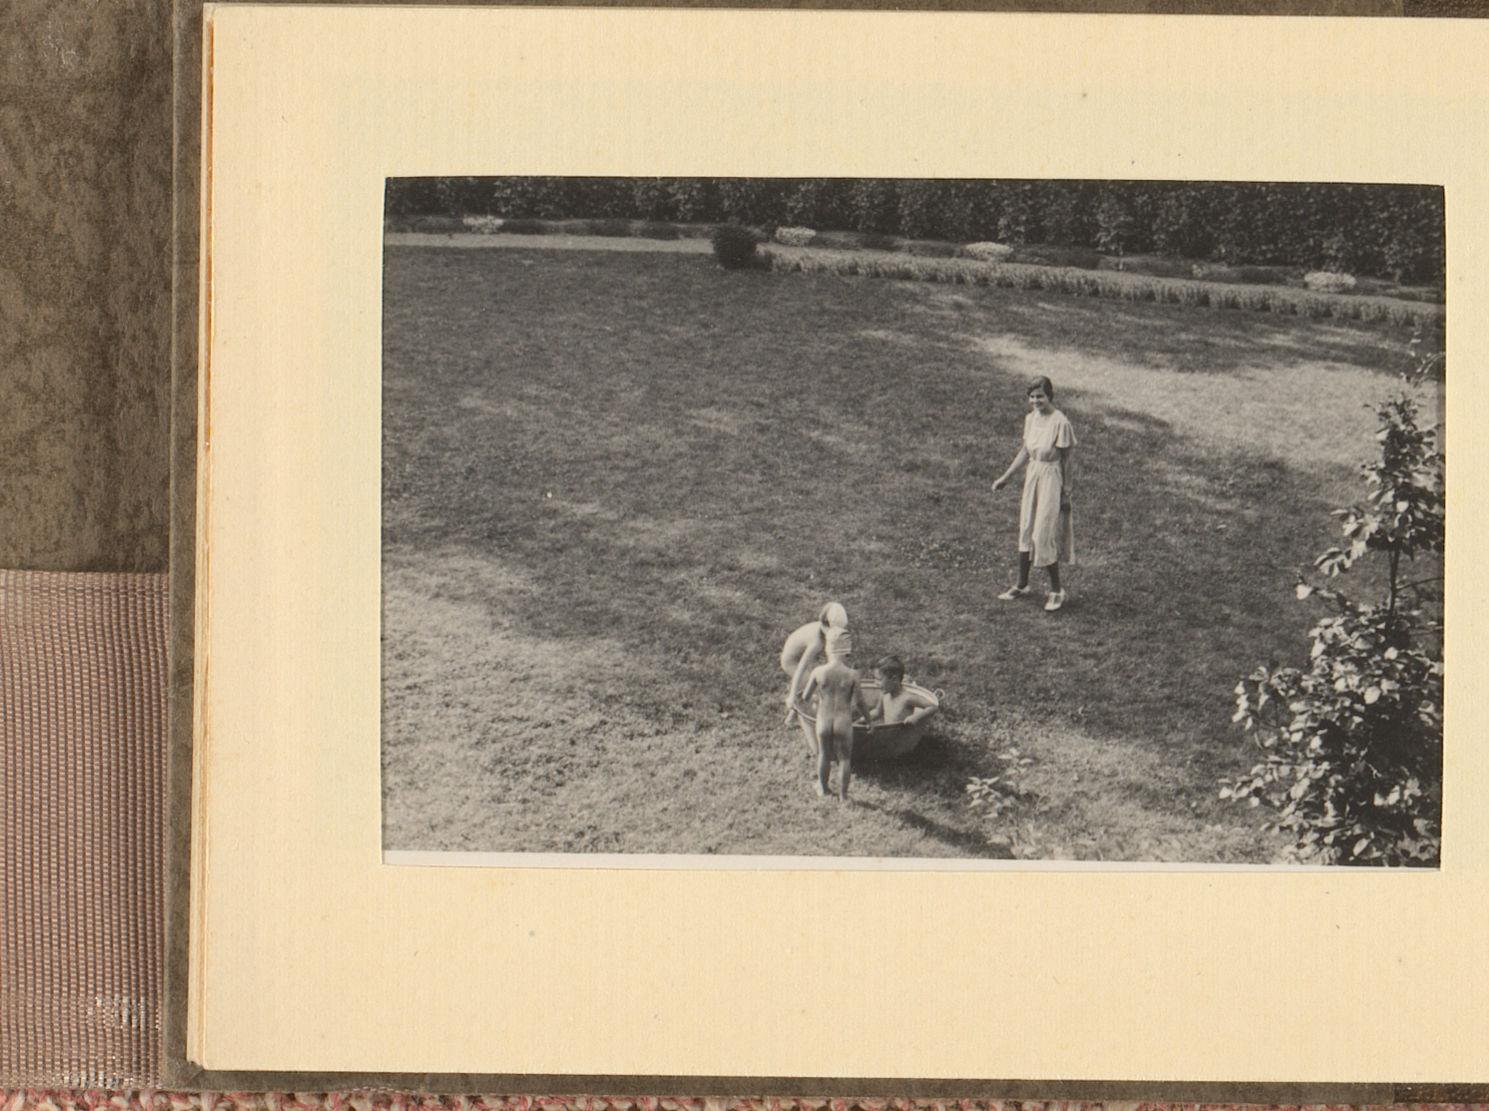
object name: album leaf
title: Isabel Wachenheimer in de tobbe met twee onbekende kinderen, en het kindermeisje ernaast, juli-augustus 1933, Hamburg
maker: else wachenheimer-moos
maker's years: 1895-1944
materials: paper, photographic support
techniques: gelatin silver print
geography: hamburg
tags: leiden, isabel wachenheimer-elon, the family travelling, on holiday, children's games and plays, tub-bath - aa - in the open air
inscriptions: date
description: Albumblad bevat een foto van Isabel Wachenheimer (met badmuts), het kindermeisje (in lichte jurk) en twee onbekende kinderen. Onderdeel van het fotoalbum Hamburg zomer 1933.